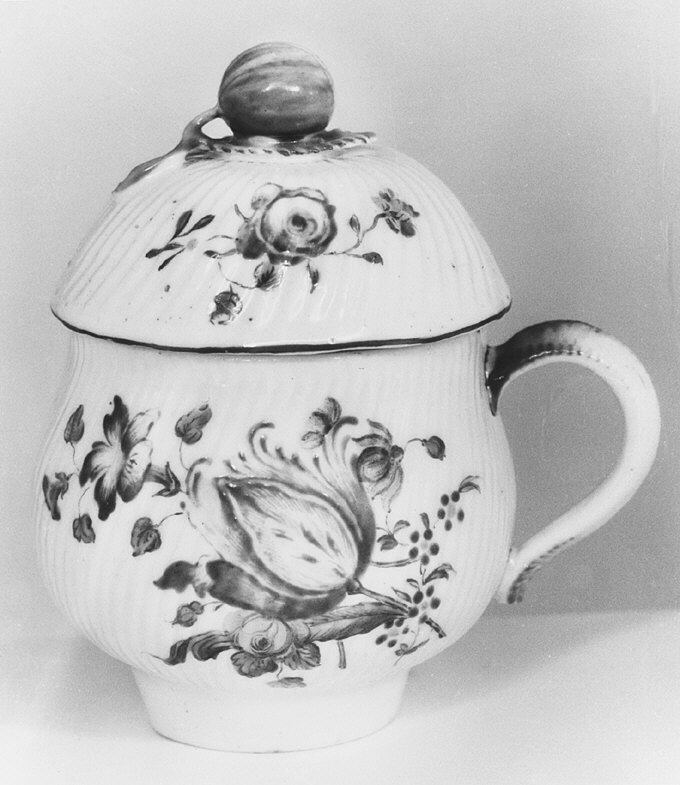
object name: cream pot with cover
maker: marieberg manufactory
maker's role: manufactory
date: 1766-1769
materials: soft paste porcelain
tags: flowers